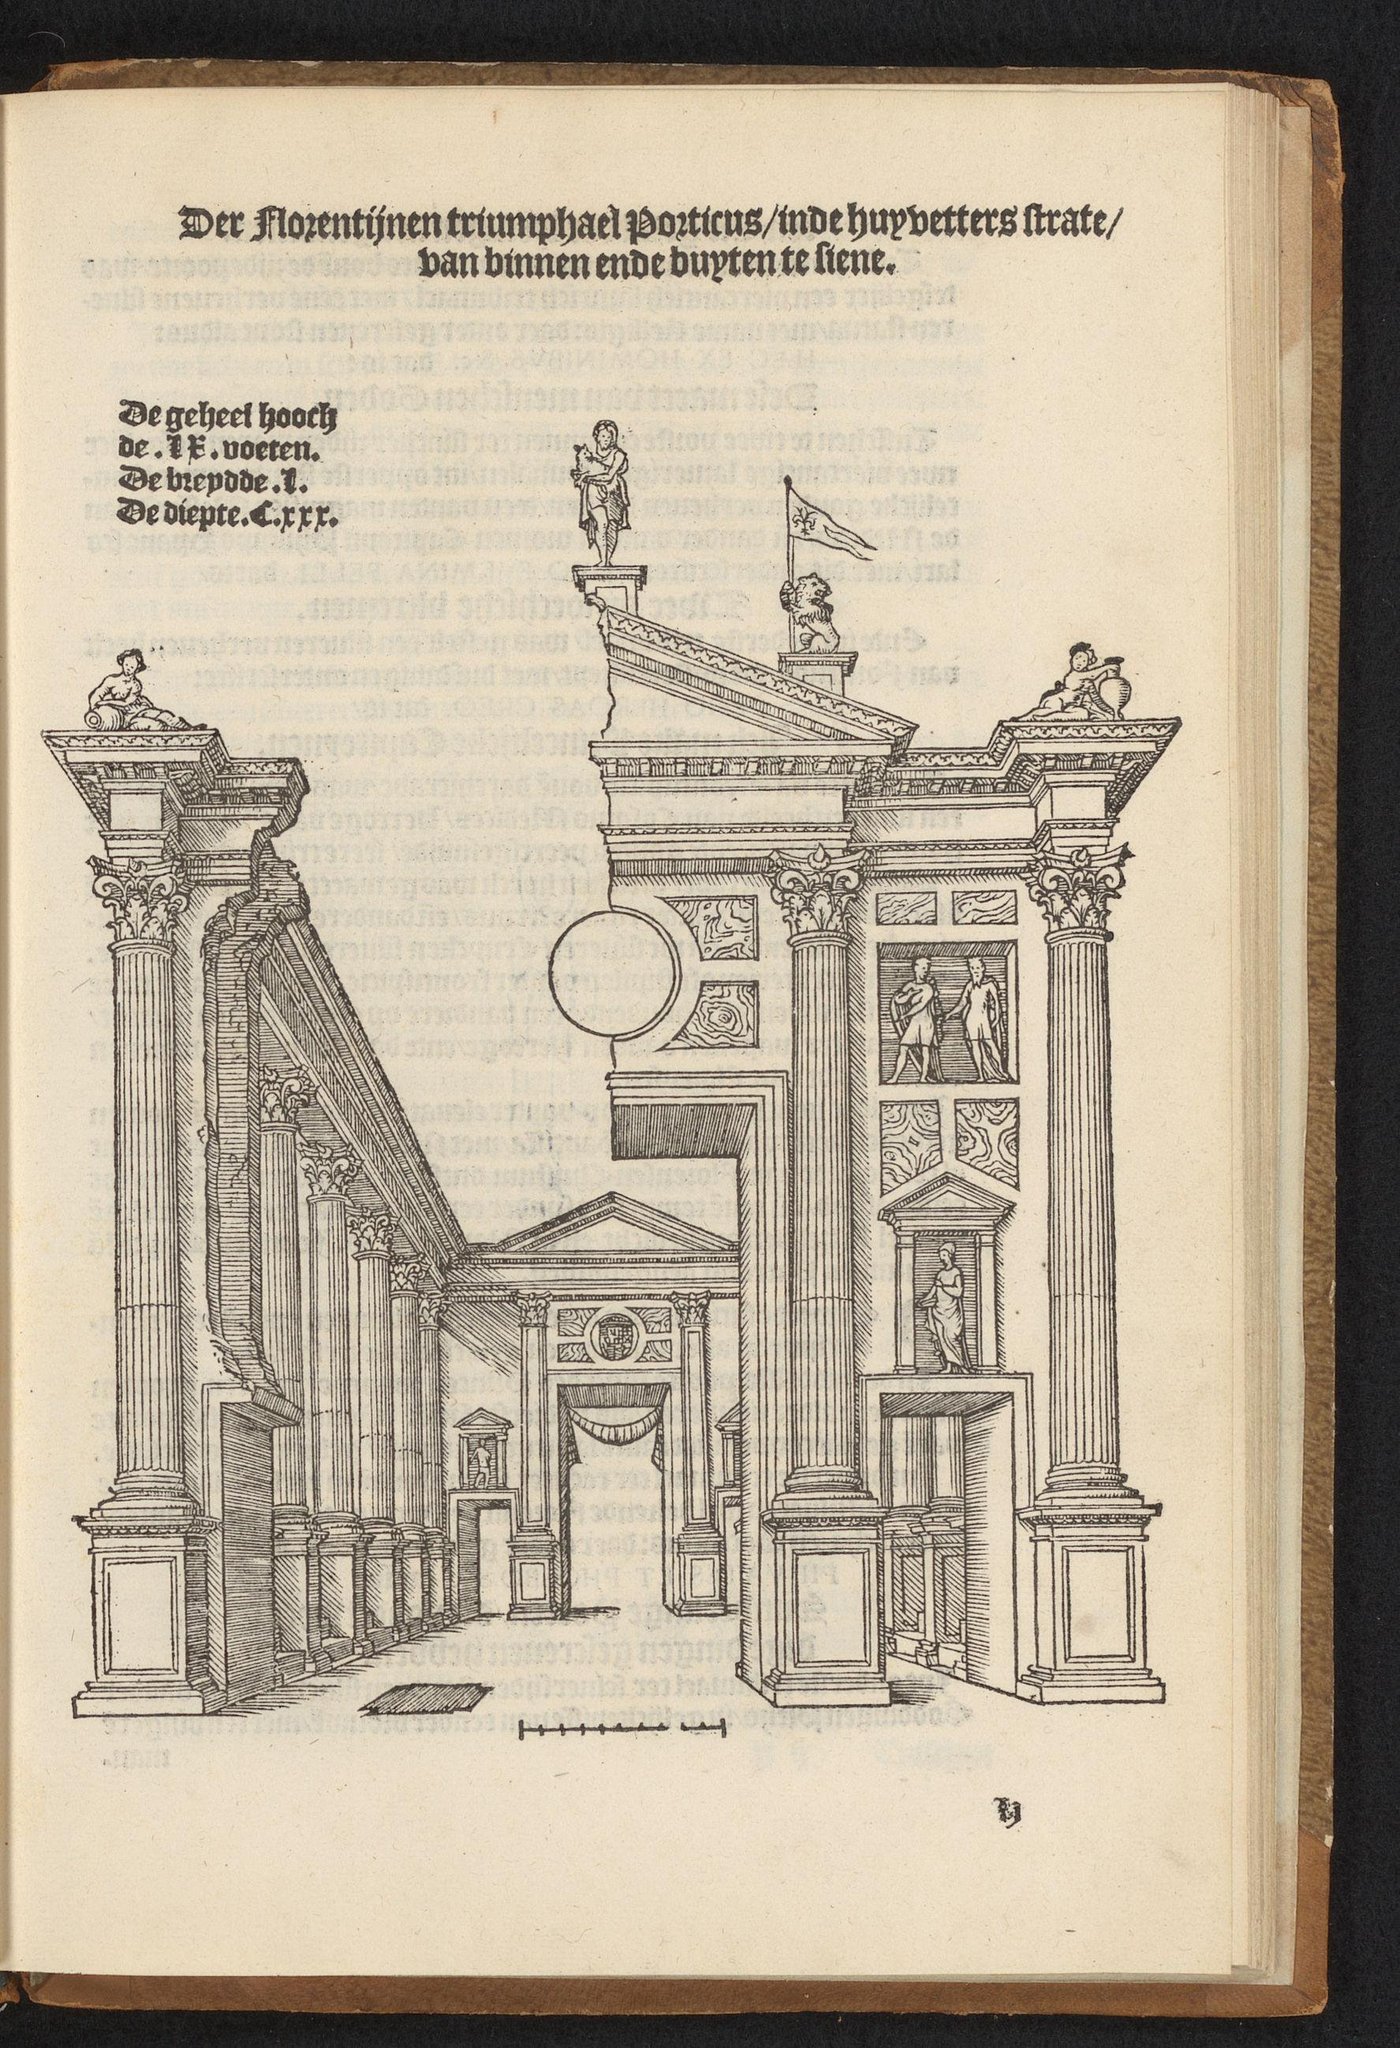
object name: print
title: De florentijnen triumphael Porticus / inde huyvetters starte / van binnen ende buyten te siene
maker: pieter coecke van aelst (i)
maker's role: draughtsman, print maker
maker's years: 1502-1550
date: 1549-1550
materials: paper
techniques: woodcut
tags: philip ii of spain, triumphal arch, antwerp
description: Illustratie in de Nederlandse vertaling van de beschrijving van de intocht van Filips II in Antwerpen in 1549: De seer wonderlijcke schoone triumphelijcke incompst, van den hooghmogenden Prince Philips, Prince van Spaignen, Caroli des vijfden, Keysers sone : inde stadt van Antwerpen, Anno 1549. Tekst van Cornelius Grapheus, waarschijnlijk vertaald uit het Latijn door Gillis van Diest, opgedragen aan Filips II, uitgegeven met keizerlijke privilege door Pieter Coecke van Aelst, gedrukt door Gillis van Diest. Boek in de bibliotheek met signatuur: 325 B 12.